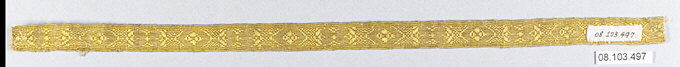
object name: galloon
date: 1701-1800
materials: cotton, silk